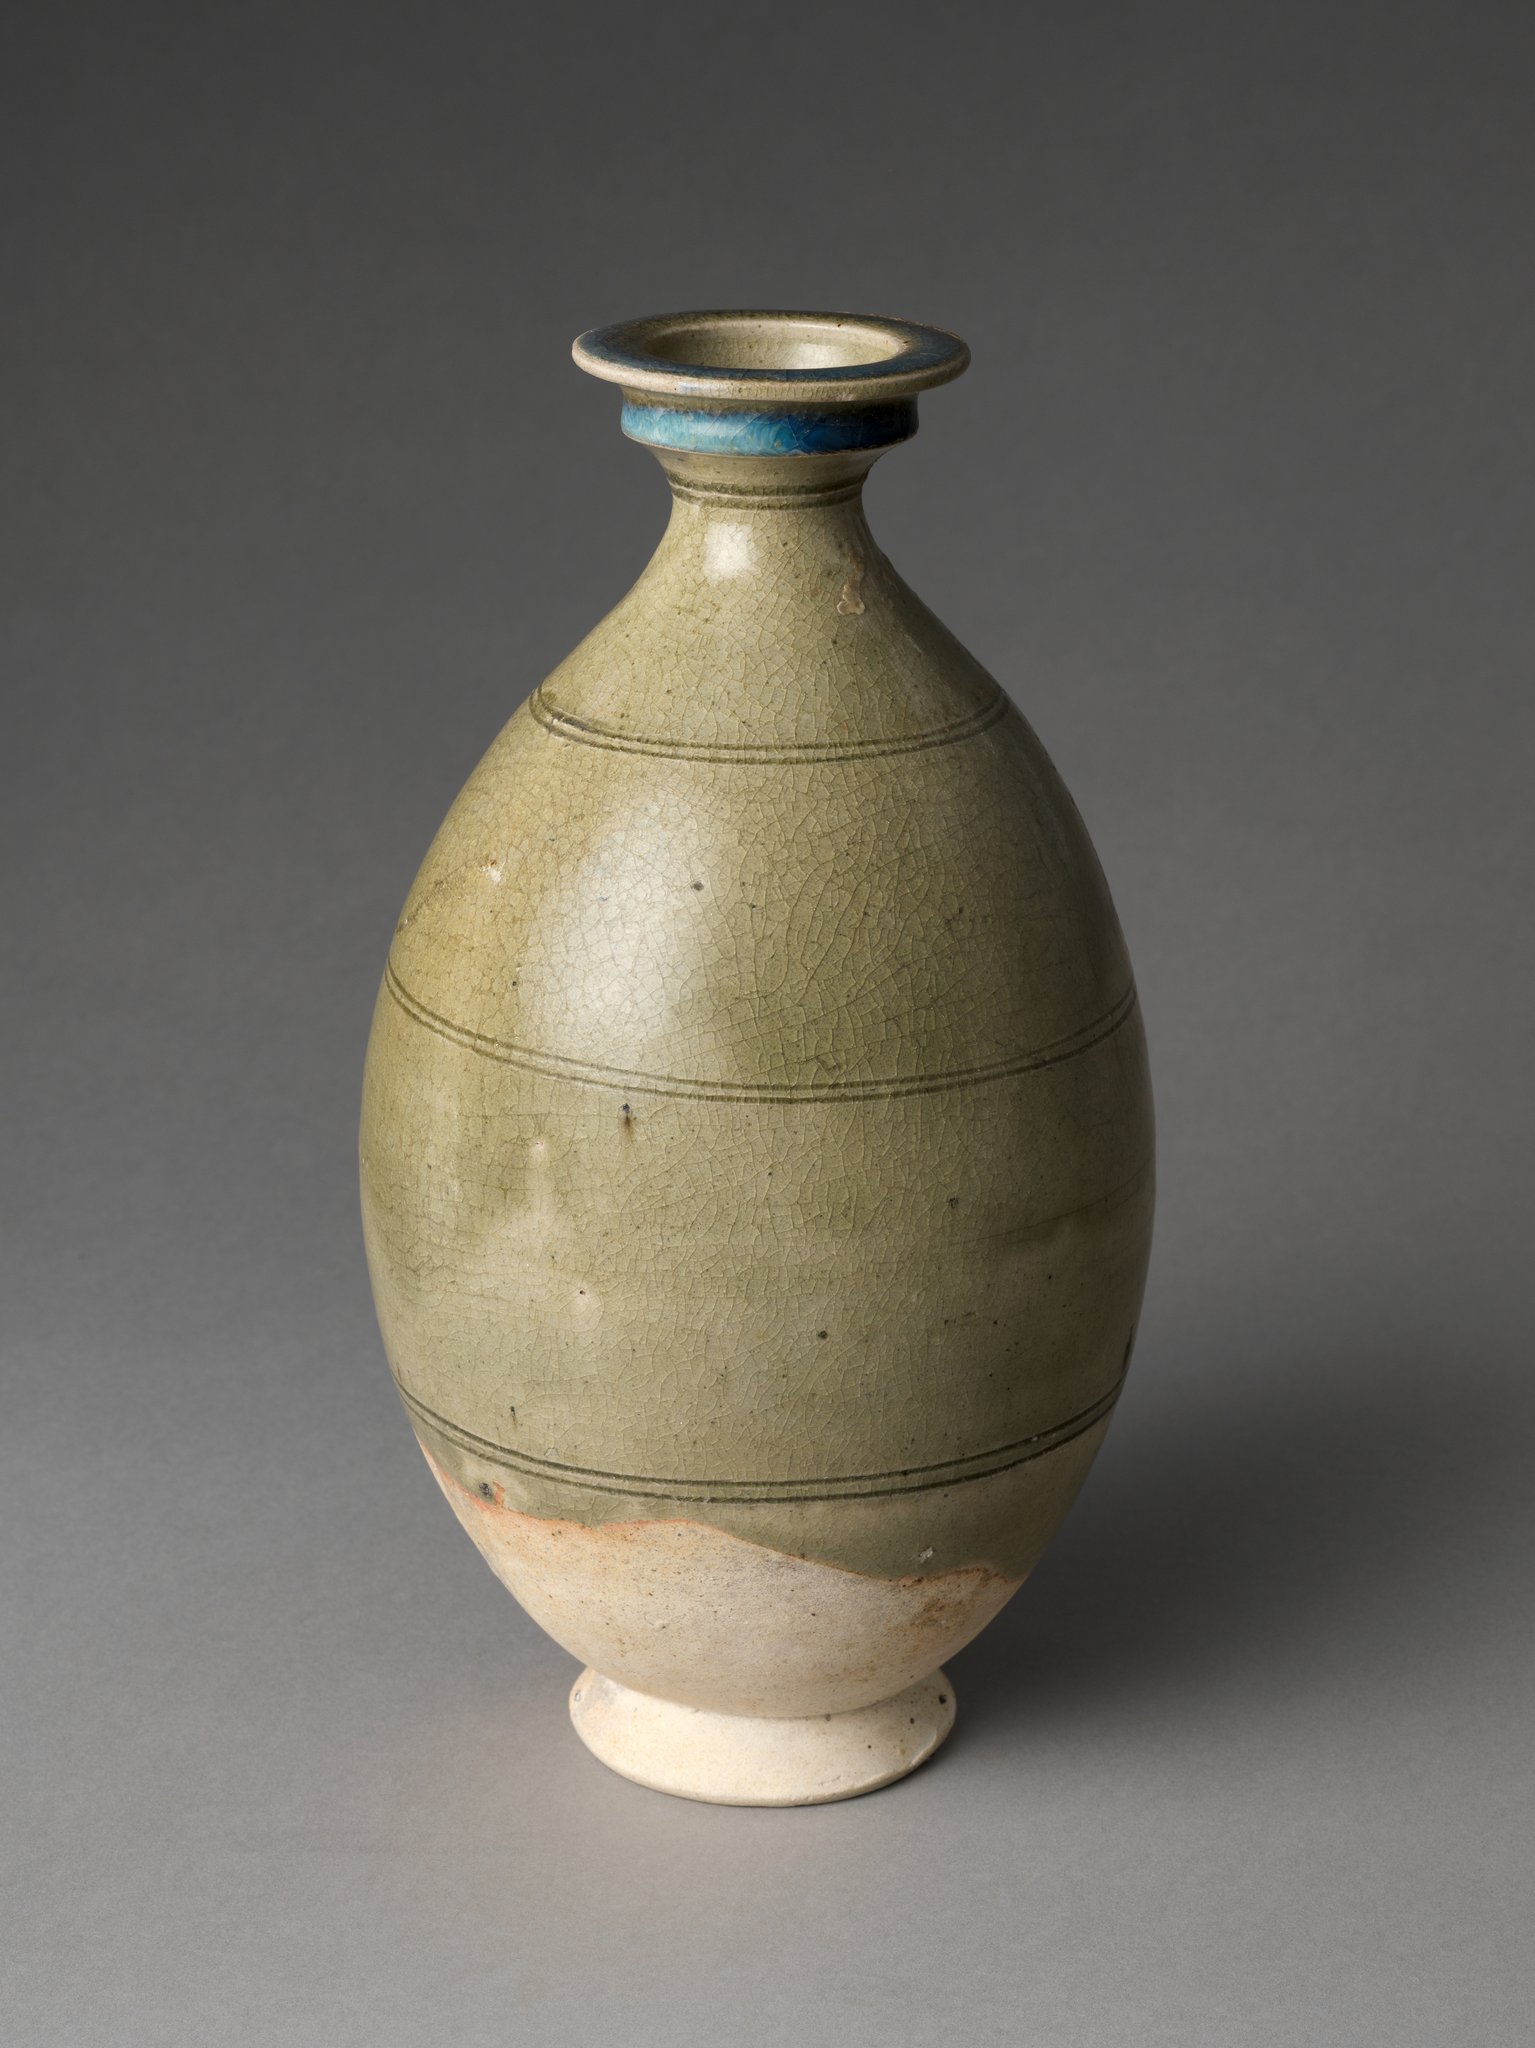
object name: bottle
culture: chinese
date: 567-633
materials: ceramic glaze, glaze, stoneware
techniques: incising